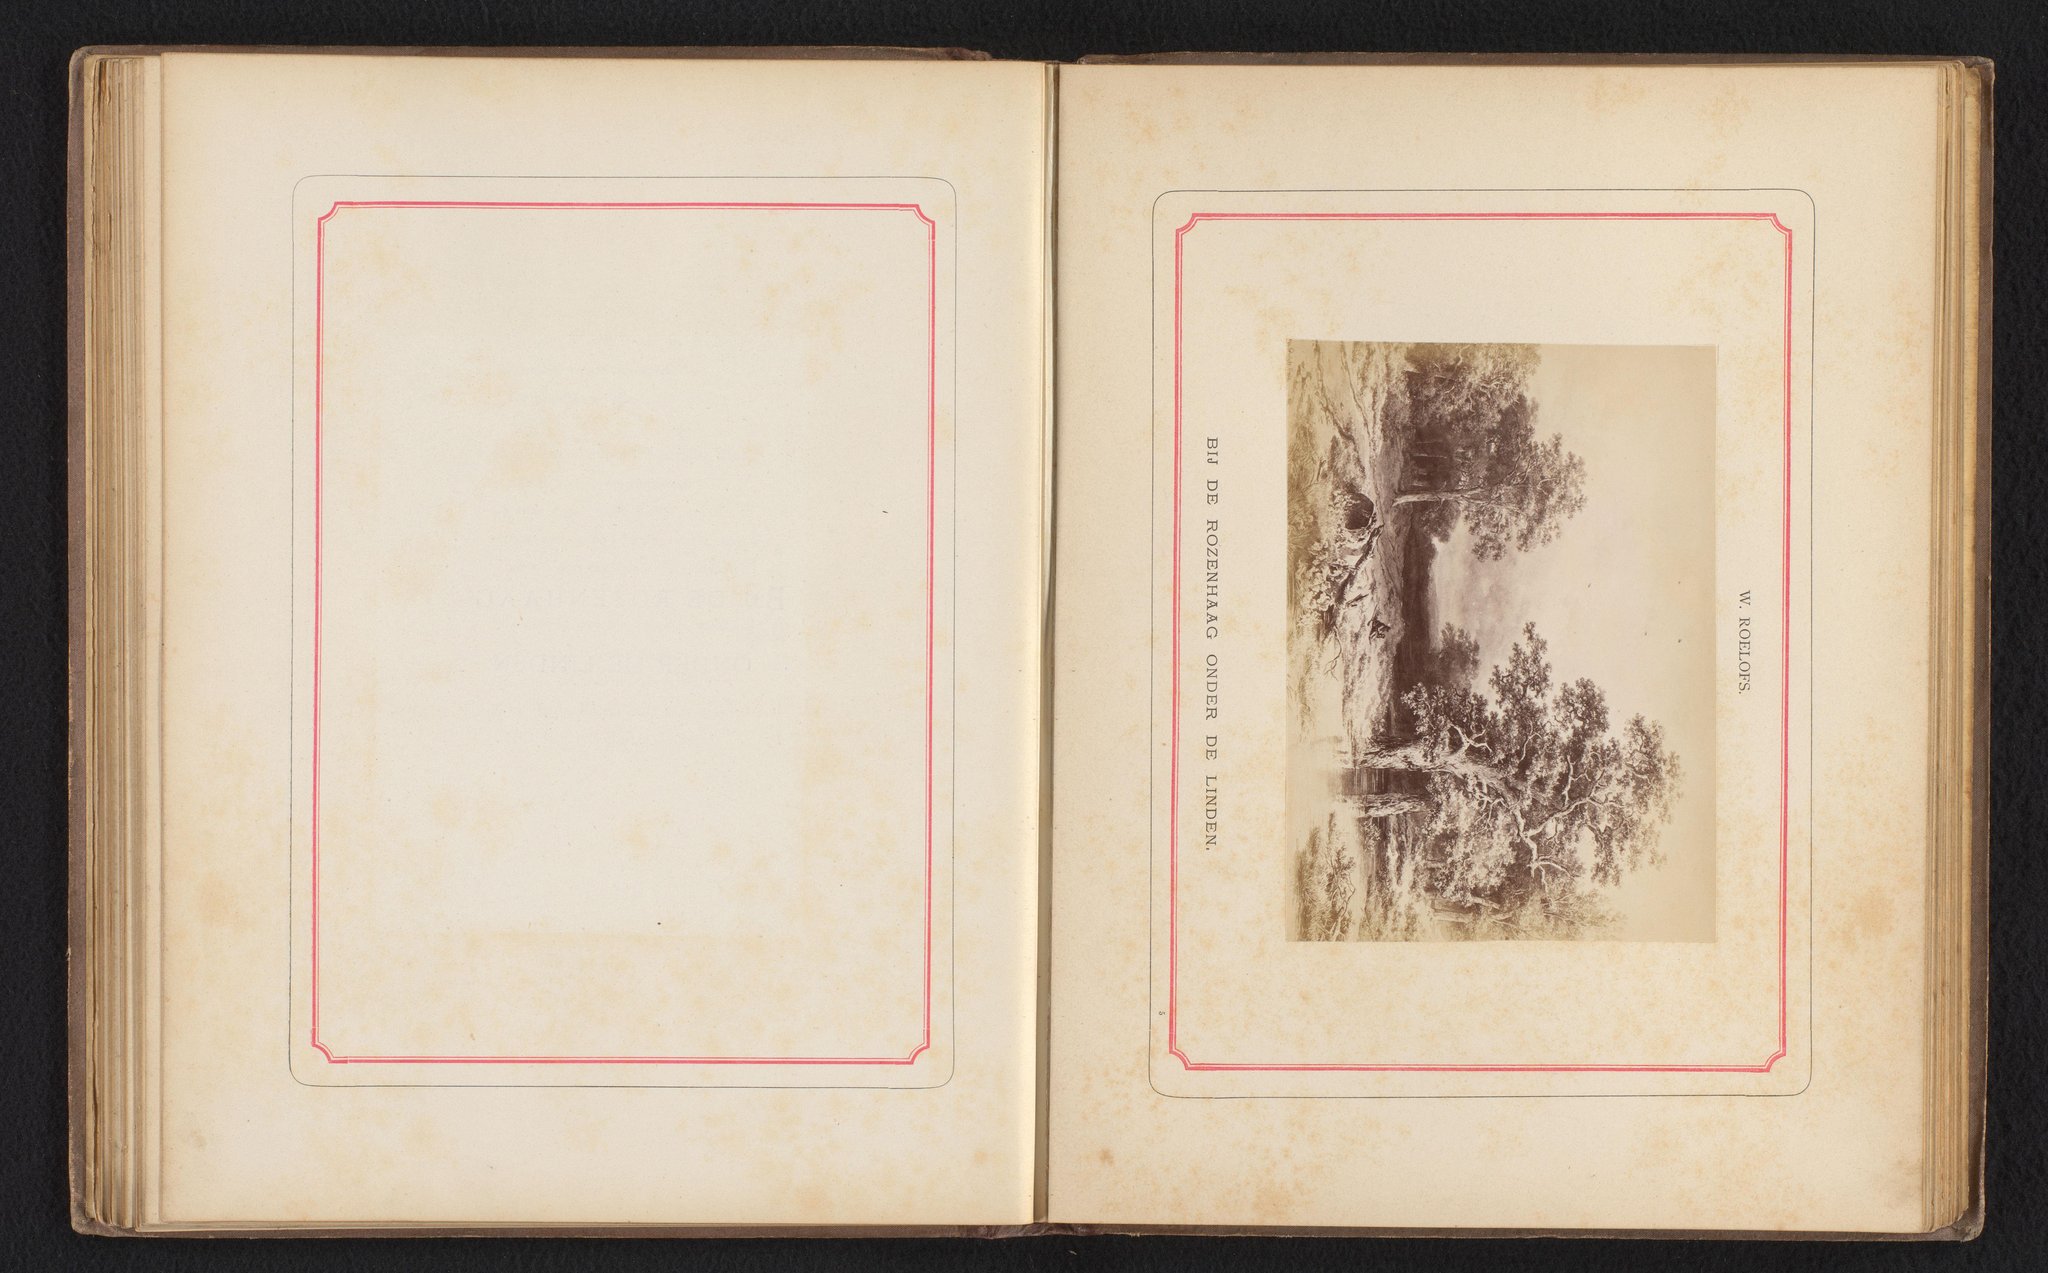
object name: reproduction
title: Fotoreproductie van het schilderij 'Bij de rozenhaag onder de linden' door Willem Roelofs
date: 1865-1878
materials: paper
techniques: albumen print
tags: forest, wood